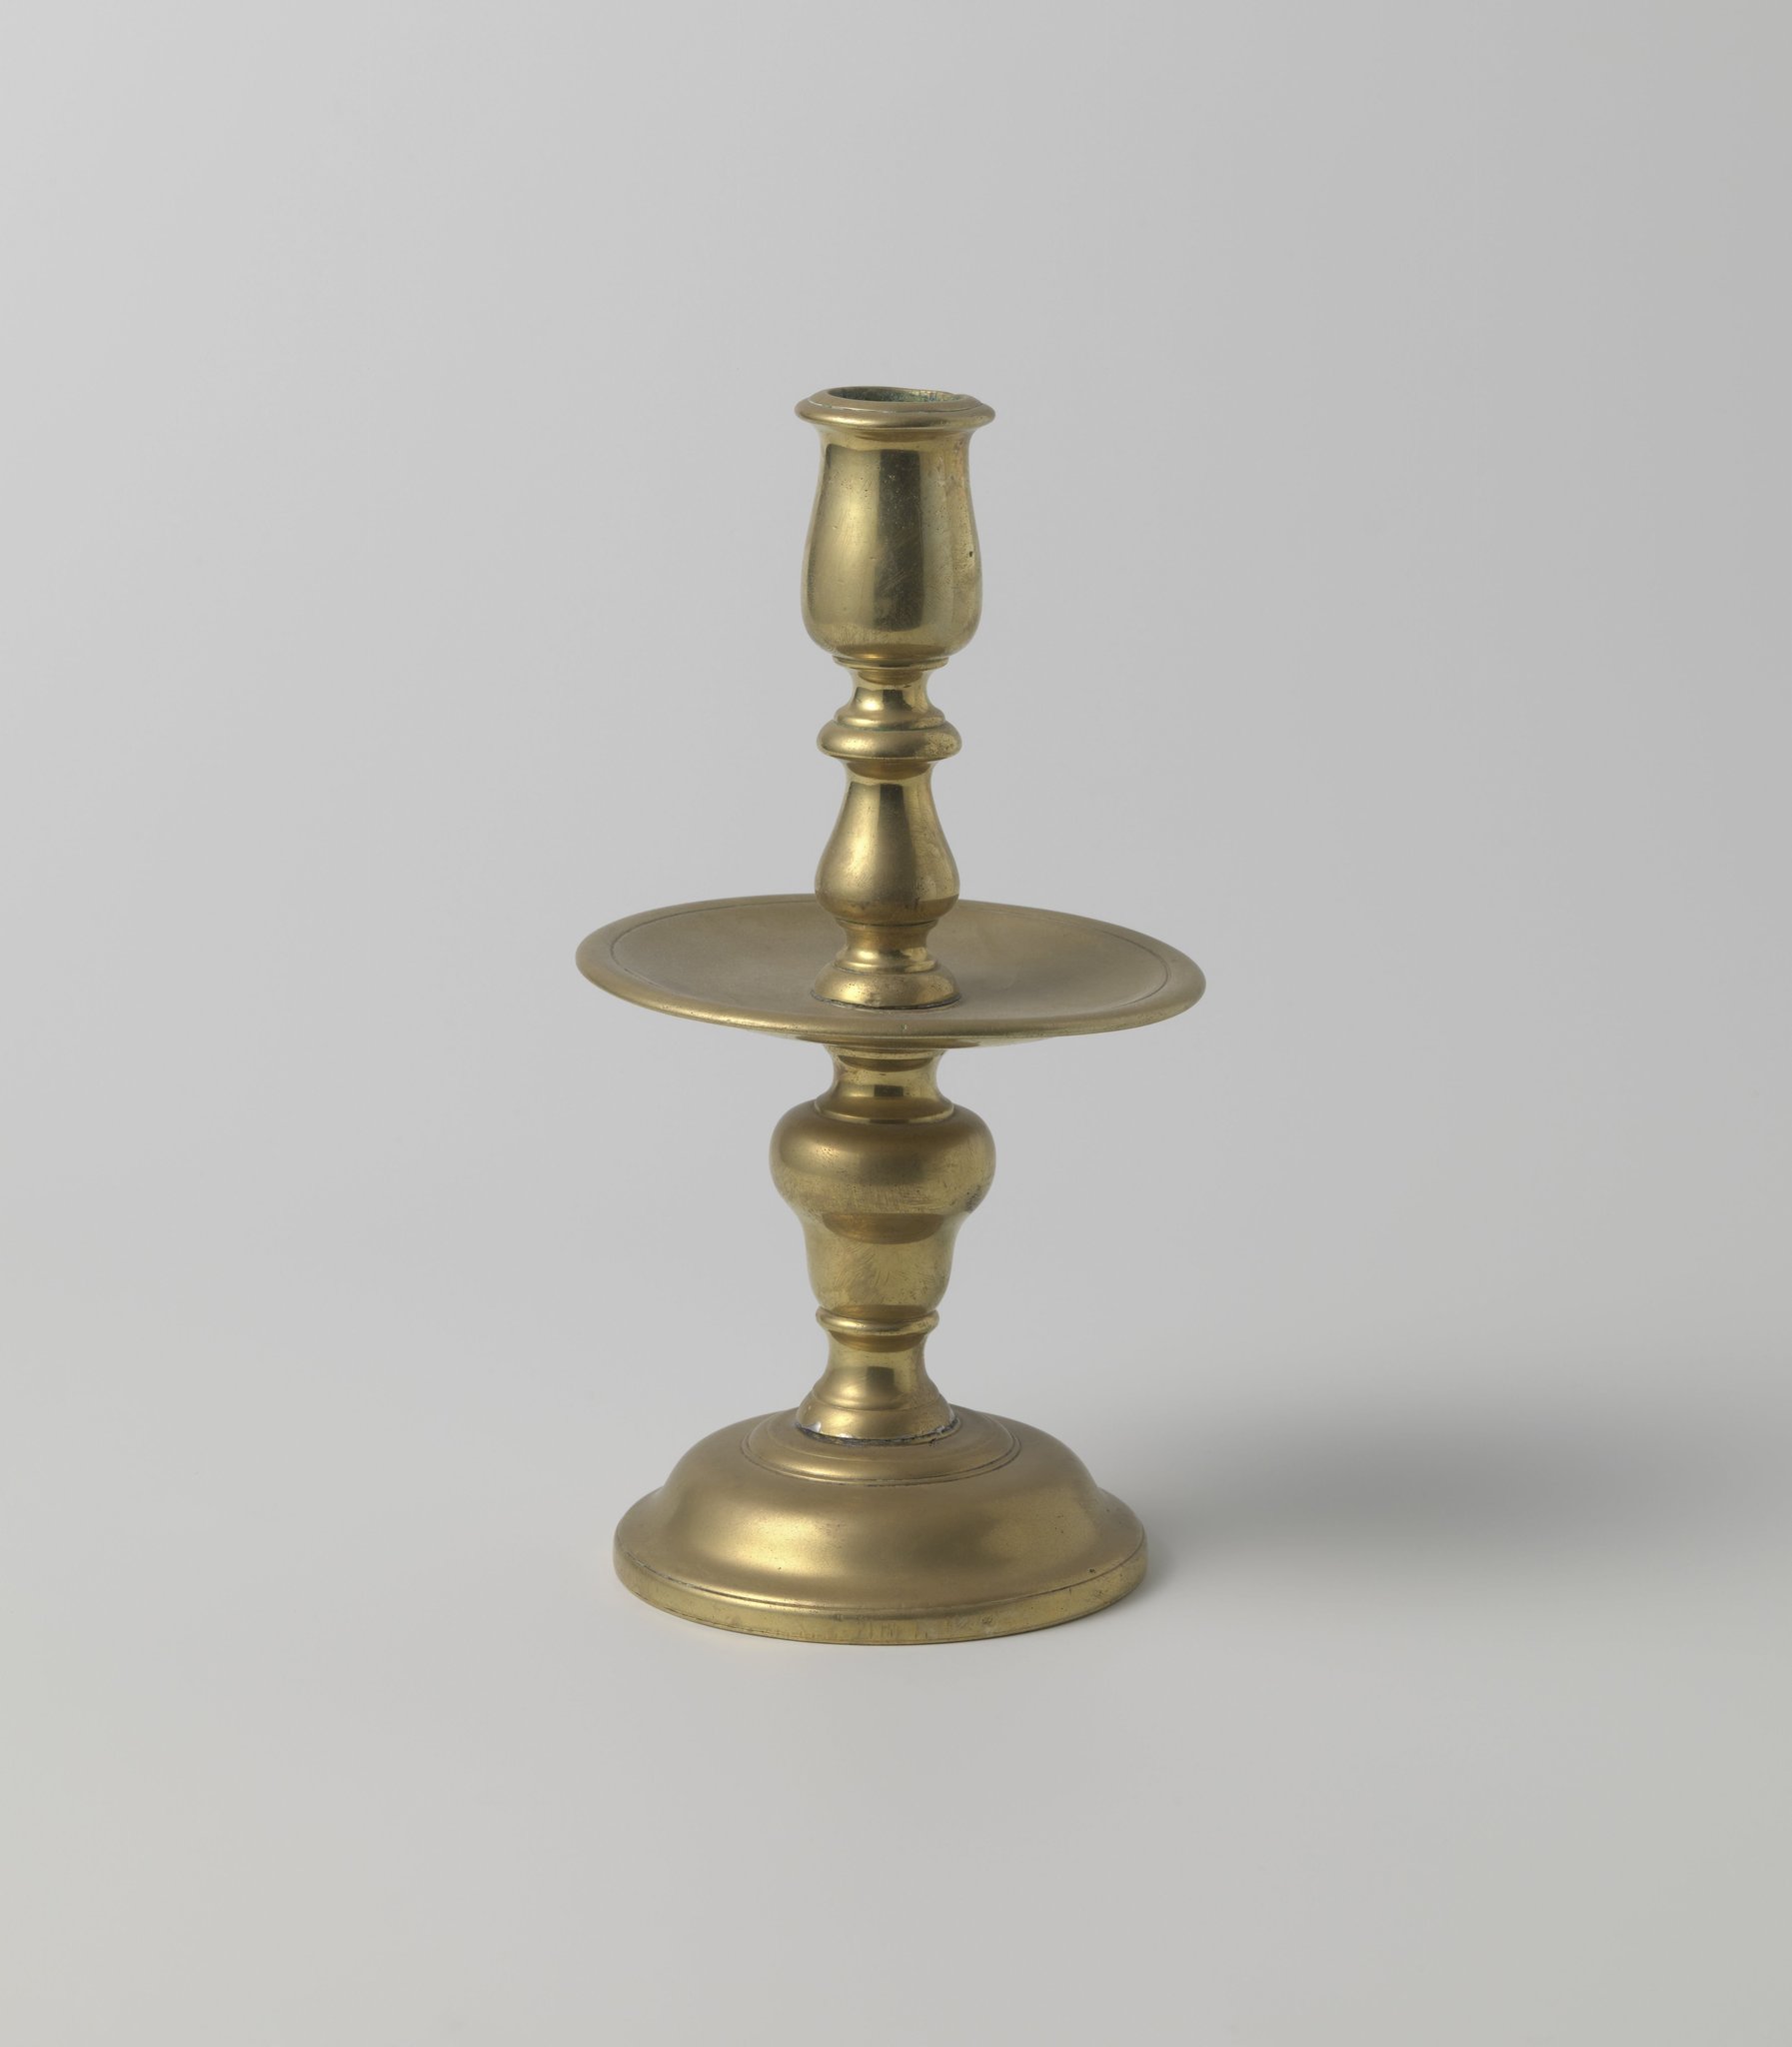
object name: candlestick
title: Kraagkandelaar van messing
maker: Anonymous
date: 1700-1725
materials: brass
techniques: casting, turning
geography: low countries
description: De kandelaar is in vier delen gegoten en afgedraaid: de voet, het onderste deel van de stam, de vetvanger, het bovenste van de stam met de kaarsenhouder. Op de geprofileerde voet volgt het onderste stamgedeelte met een vaasvormige verdikking in het midden. De kraag is aan de bovenkant met een ring versierd. Het bovenste deel van de stam is balustervormig. Zo ook de kaarsenhouder, die in het midden van de wand één ronde opening heeft. Onder de voet is de oorspronkelijke bevestigingswijze niet meer te zien ten gevolge van soldeer. Een kandelaar van dit type wordt kraag- of schijfkandelaar genoemd.